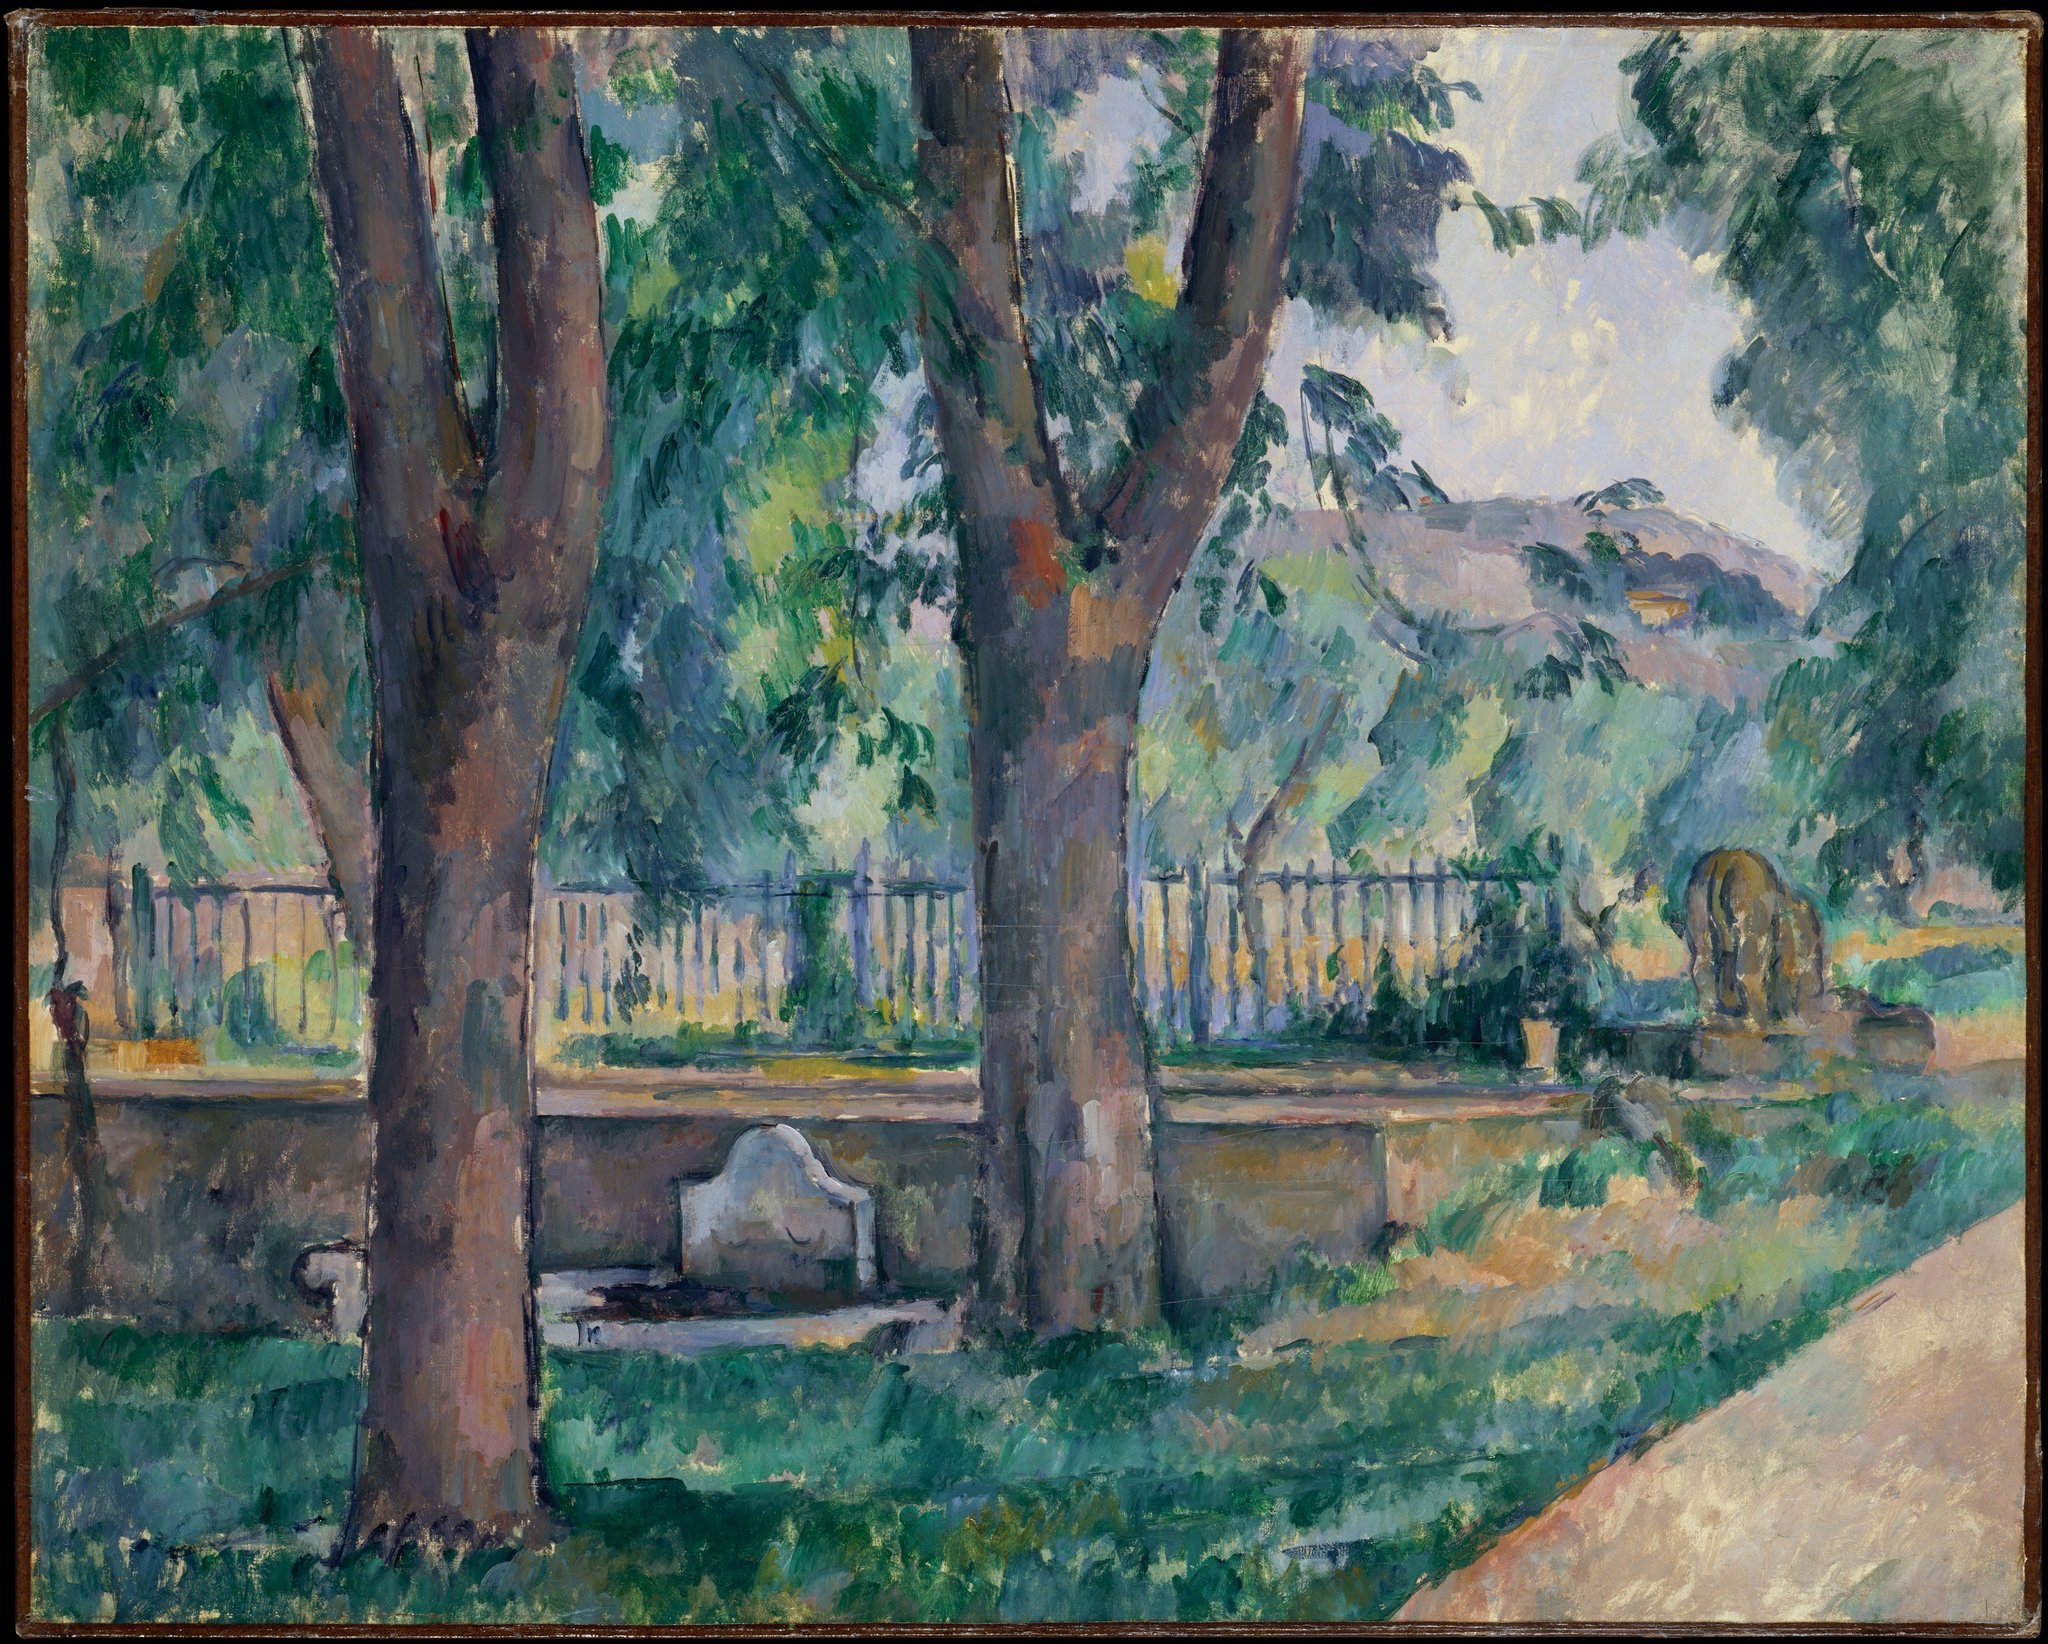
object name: painting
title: The Pool at Jas de Bouffan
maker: paul cézanne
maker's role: artist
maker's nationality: french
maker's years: 1839-1906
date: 1885-1886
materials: canvas, oil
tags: gardens,landscapes